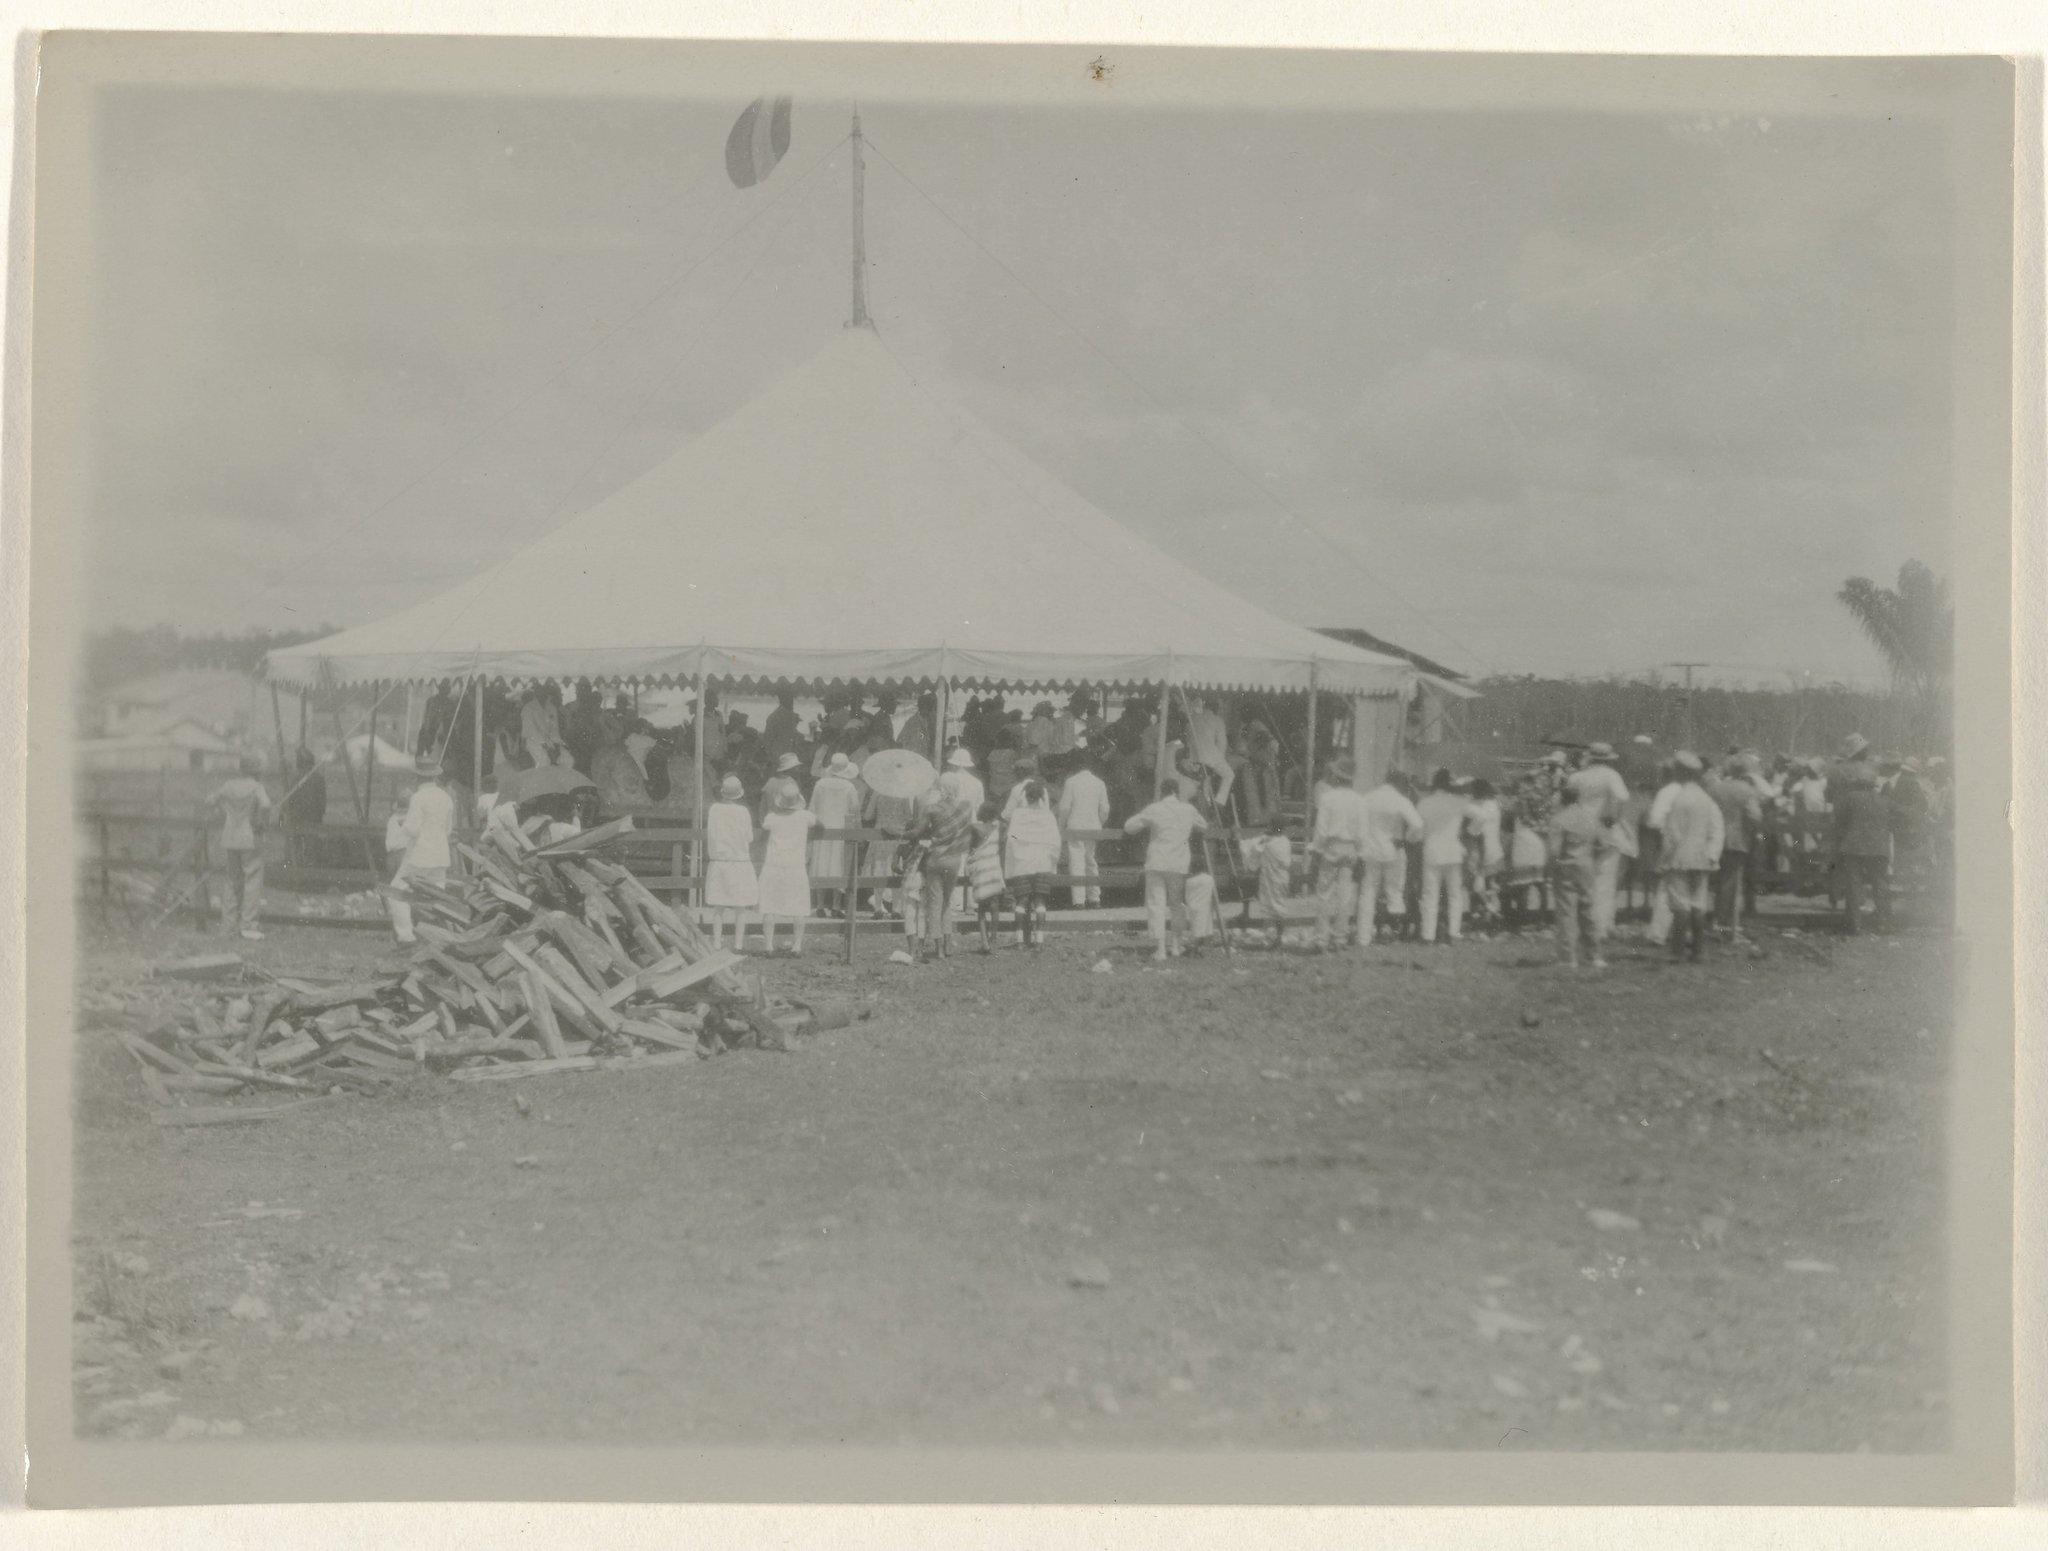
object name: photograph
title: Feestelijkheden in Moengo in een tent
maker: Anonymous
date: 1929-1930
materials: photographic support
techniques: photography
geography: suriname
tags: albina, moengo